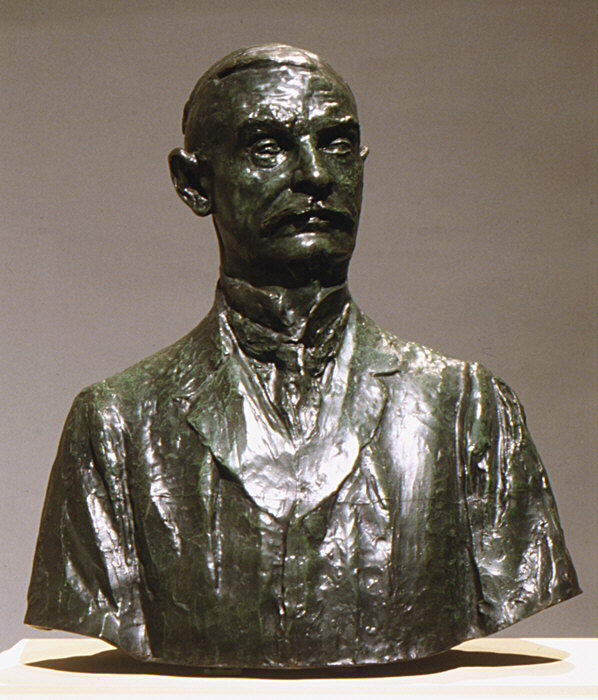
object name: bust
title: Thomas Fortune Ryan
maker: auguste rodin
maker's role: artist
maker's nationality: french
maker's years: 1840-1917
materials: bronze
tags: men,portraits